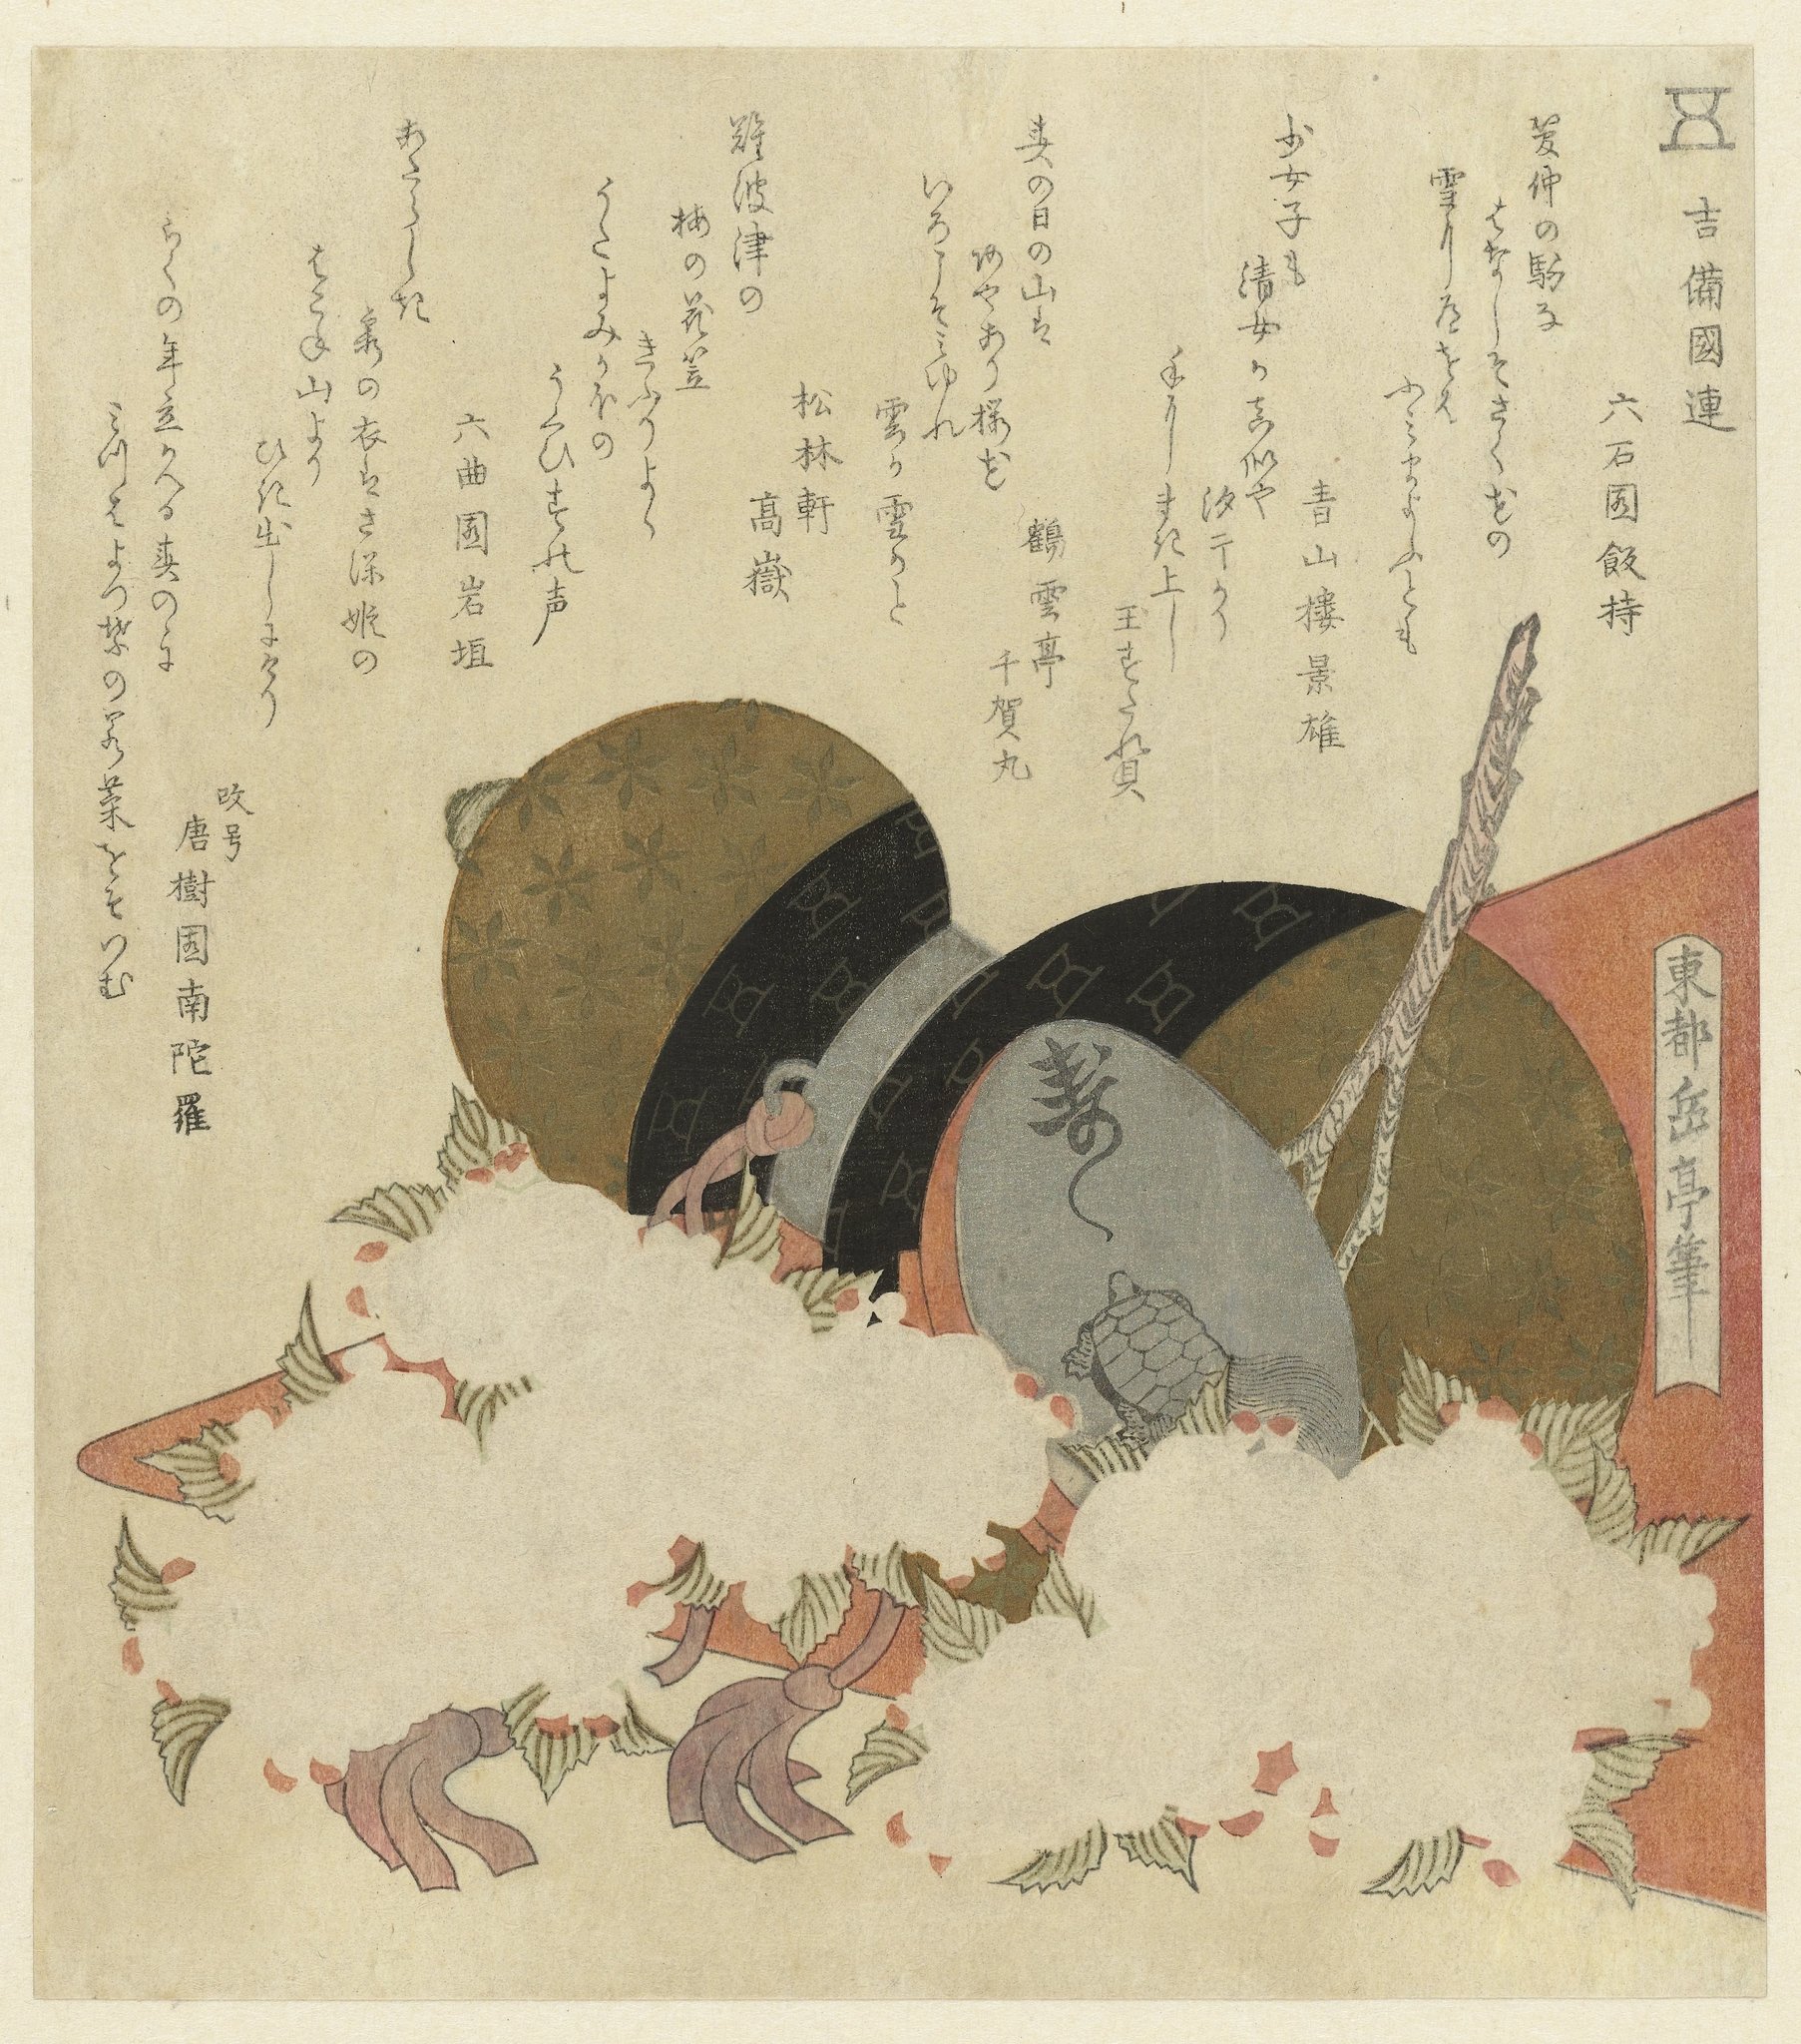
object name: surimono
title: Still Life with a Gourd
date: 1822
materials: paper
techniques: blind stamped, woodcut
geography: japan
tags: fruits: gourd, tortoises, turtles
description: Even though no horse is depicted in this print, it was made for the Year of the Horse. The horse is indicated by the calabash, which refers to the immortal Chokaro, who always carried a gourd with a horse inside. The turtle on the sake dish is a symbol of prosperity and long life. It exhales the word kotobuki, a prosperity wish for a long life.